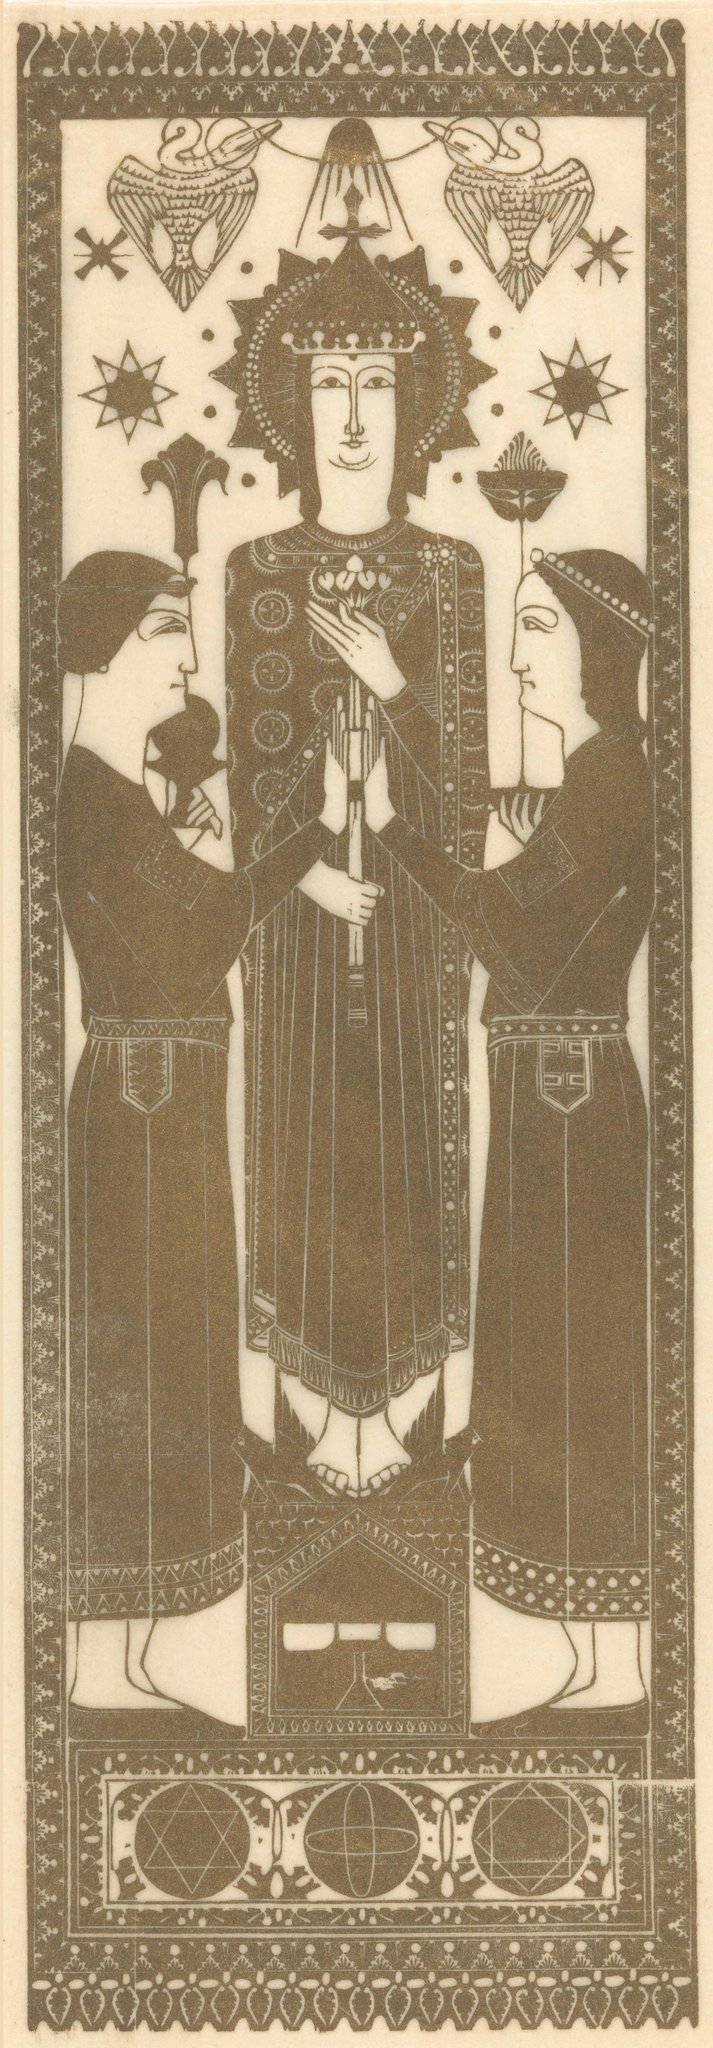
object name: print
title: Drie figuren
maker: mathieu lauweriks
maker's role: designer, draughtsman, print maker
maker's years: 1864-1932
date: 1874-1932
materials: paper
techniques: woodcut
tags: standing figure, art, religion and magic, philosophy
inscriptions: collector's mark: Lugt 2228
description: Drie figuren die godsdienst, filosofie en kunst vertegenwoordigen. Bovenaan twee vogels.